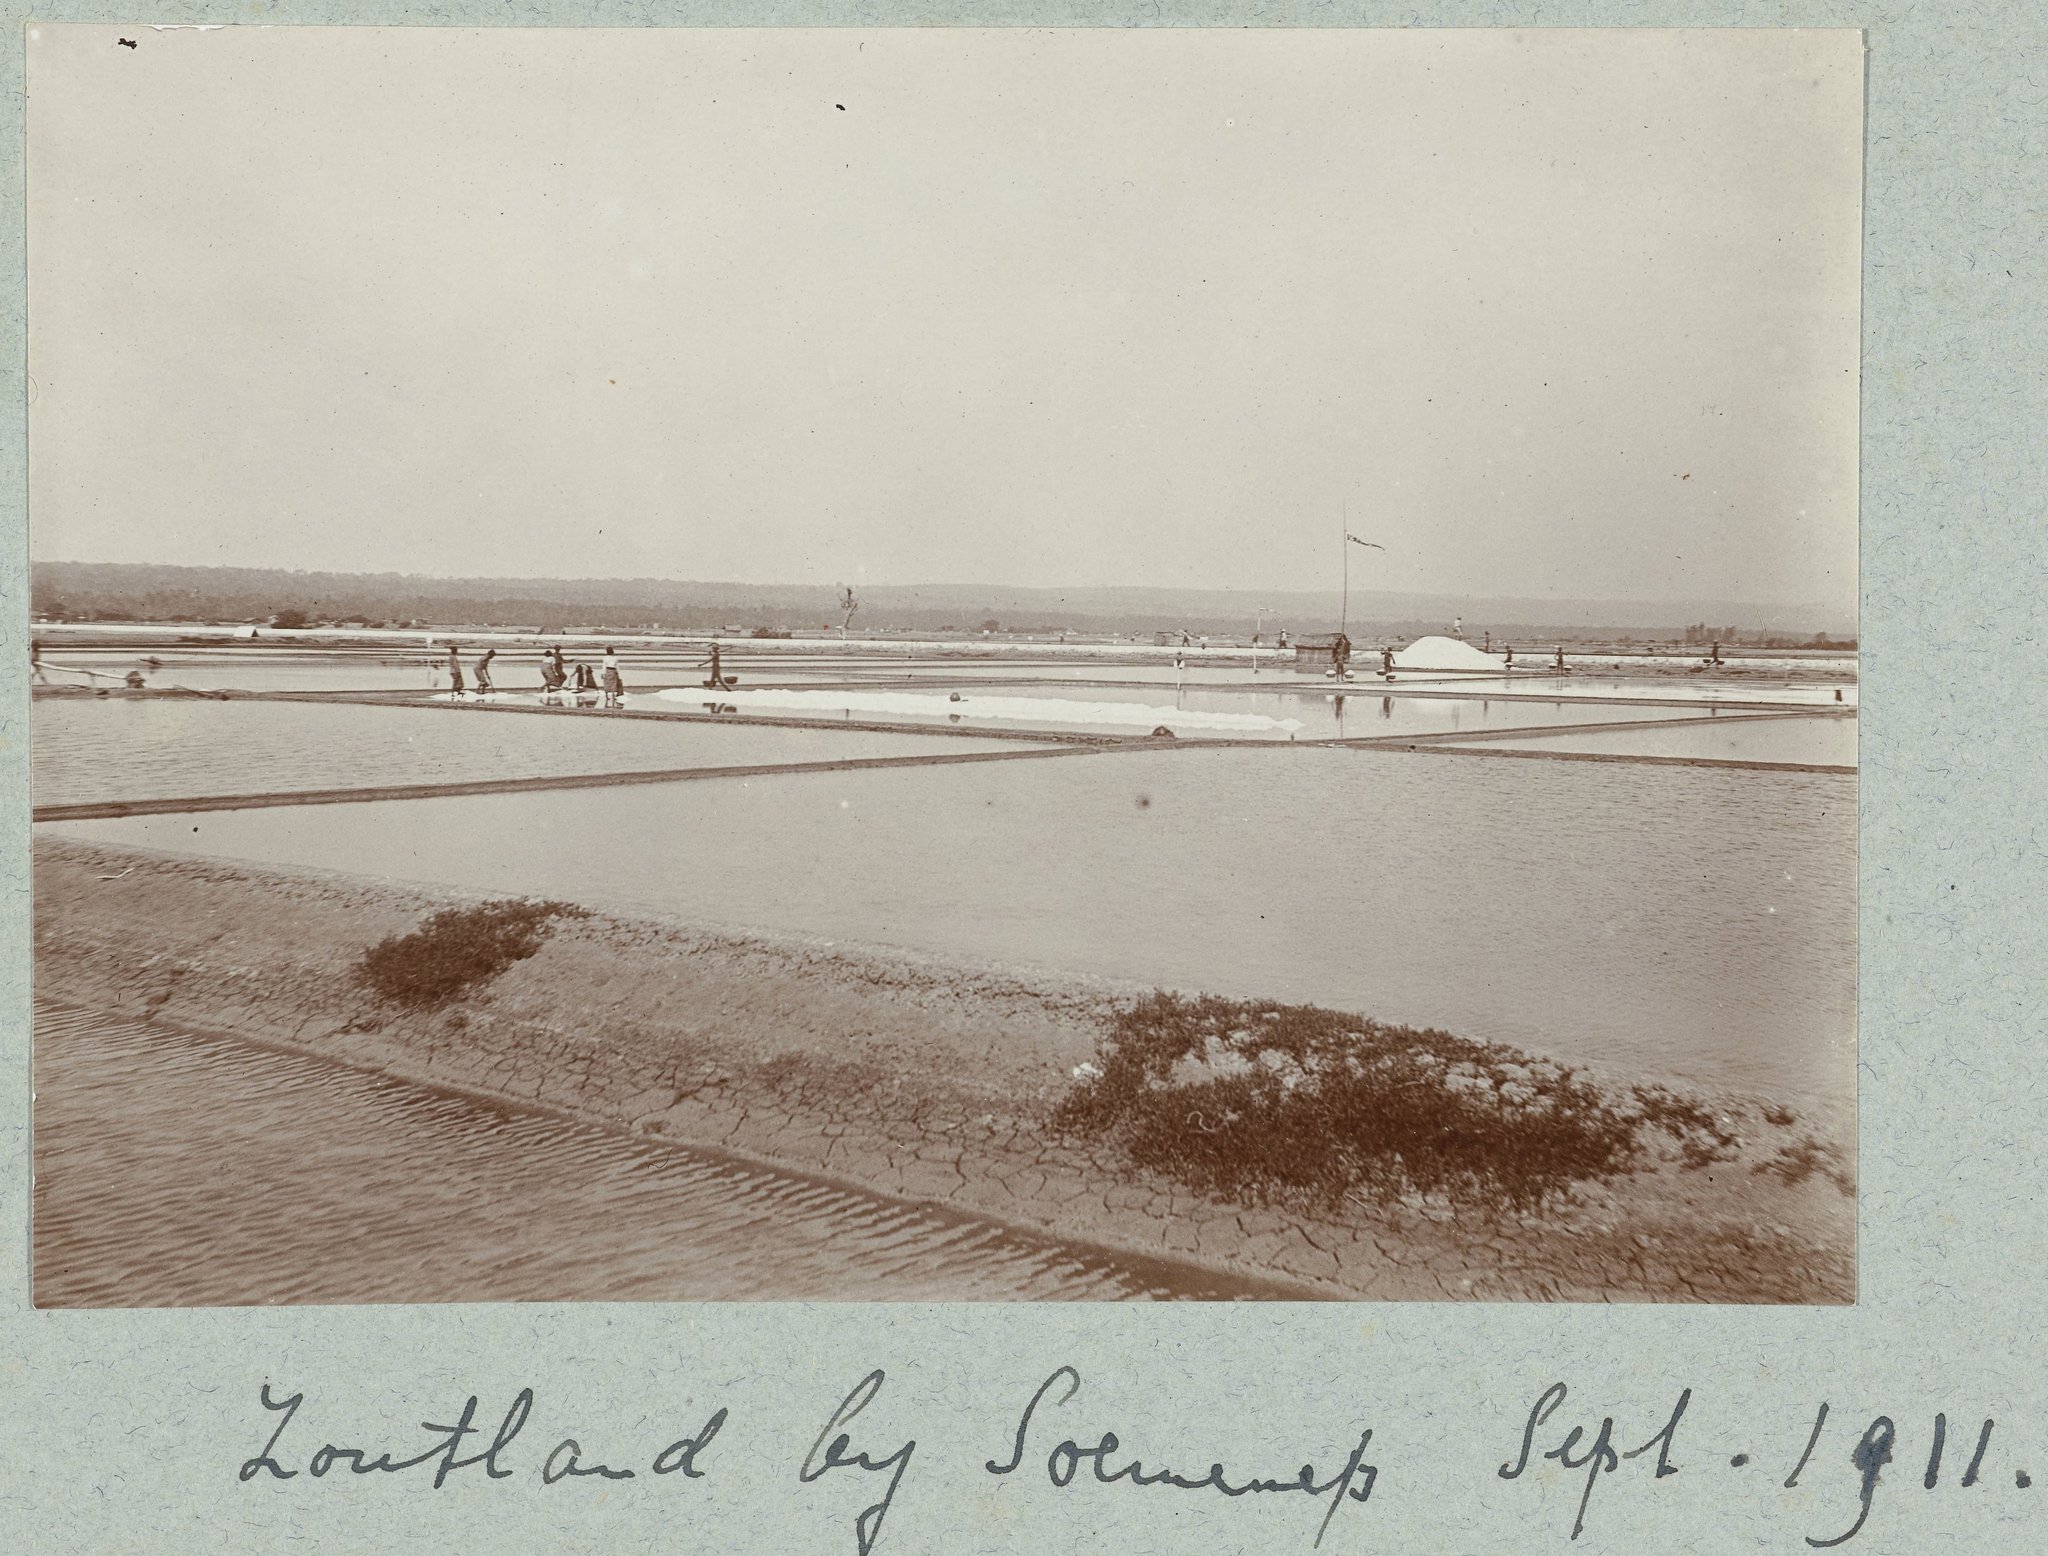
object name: photograph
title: Het filteren van zout uit zeewater op opengrond in Sumenep gelegen aan zee.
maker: frits freerks fontein fz.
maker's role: fotograaf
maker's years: 1882-1928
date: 1910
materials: cardboard, paper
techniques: gelatin silver print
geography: madura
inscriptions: caption: ‘Zoutland bij Soemenep Sept 1911’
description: Een aantal Indonesische kinderen loopt op blote voeten door het zout houdende water en vegen het zout uit het sterk geconcentreerde water op hopen. Foto uit album 'Photographieën".